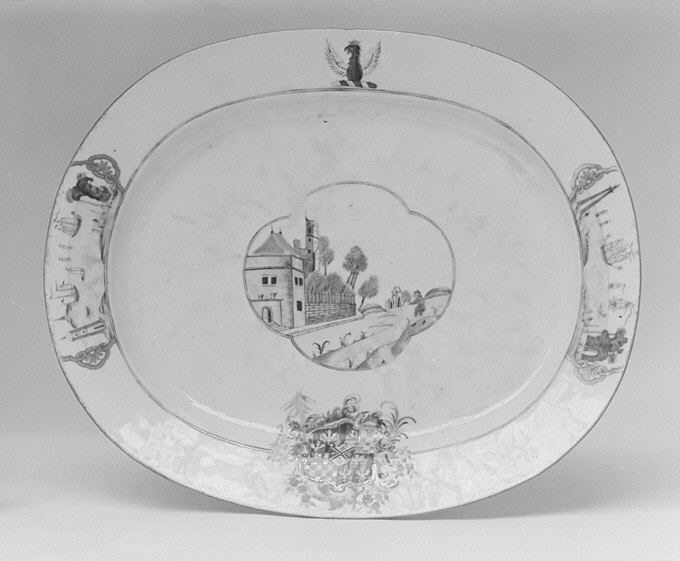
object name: platter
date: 1745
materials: hard paste porcelain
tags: birds,buildings,coat of arms